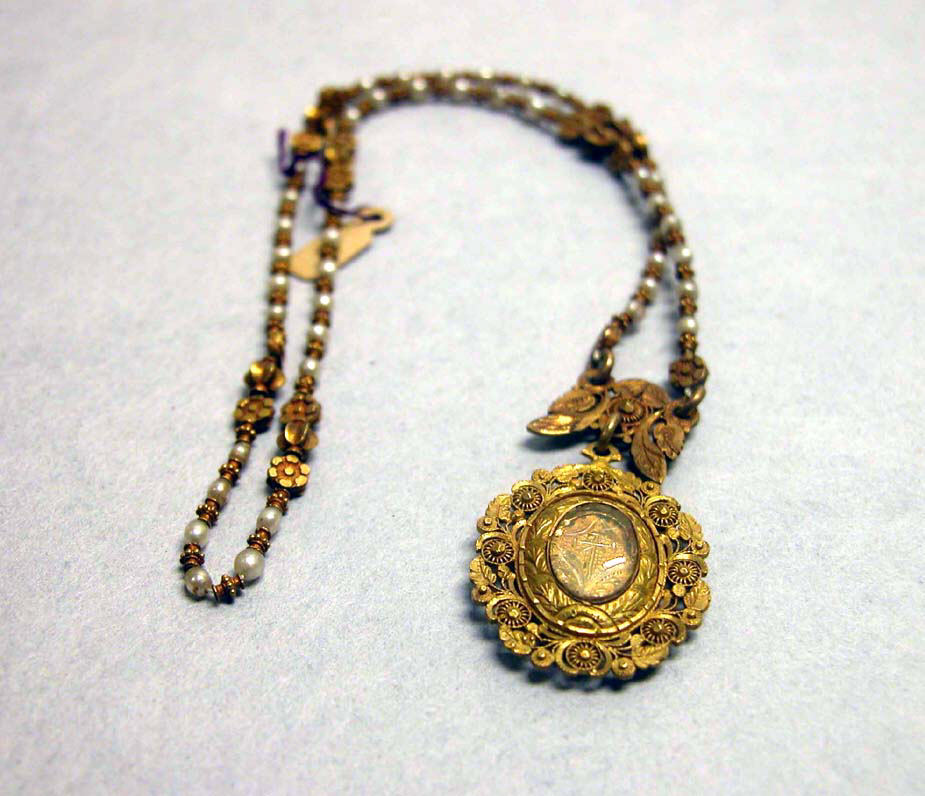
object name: necklace or rosary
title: Necklace or Rosary (?)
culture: filipino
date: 1601-1900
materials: gold, pearl